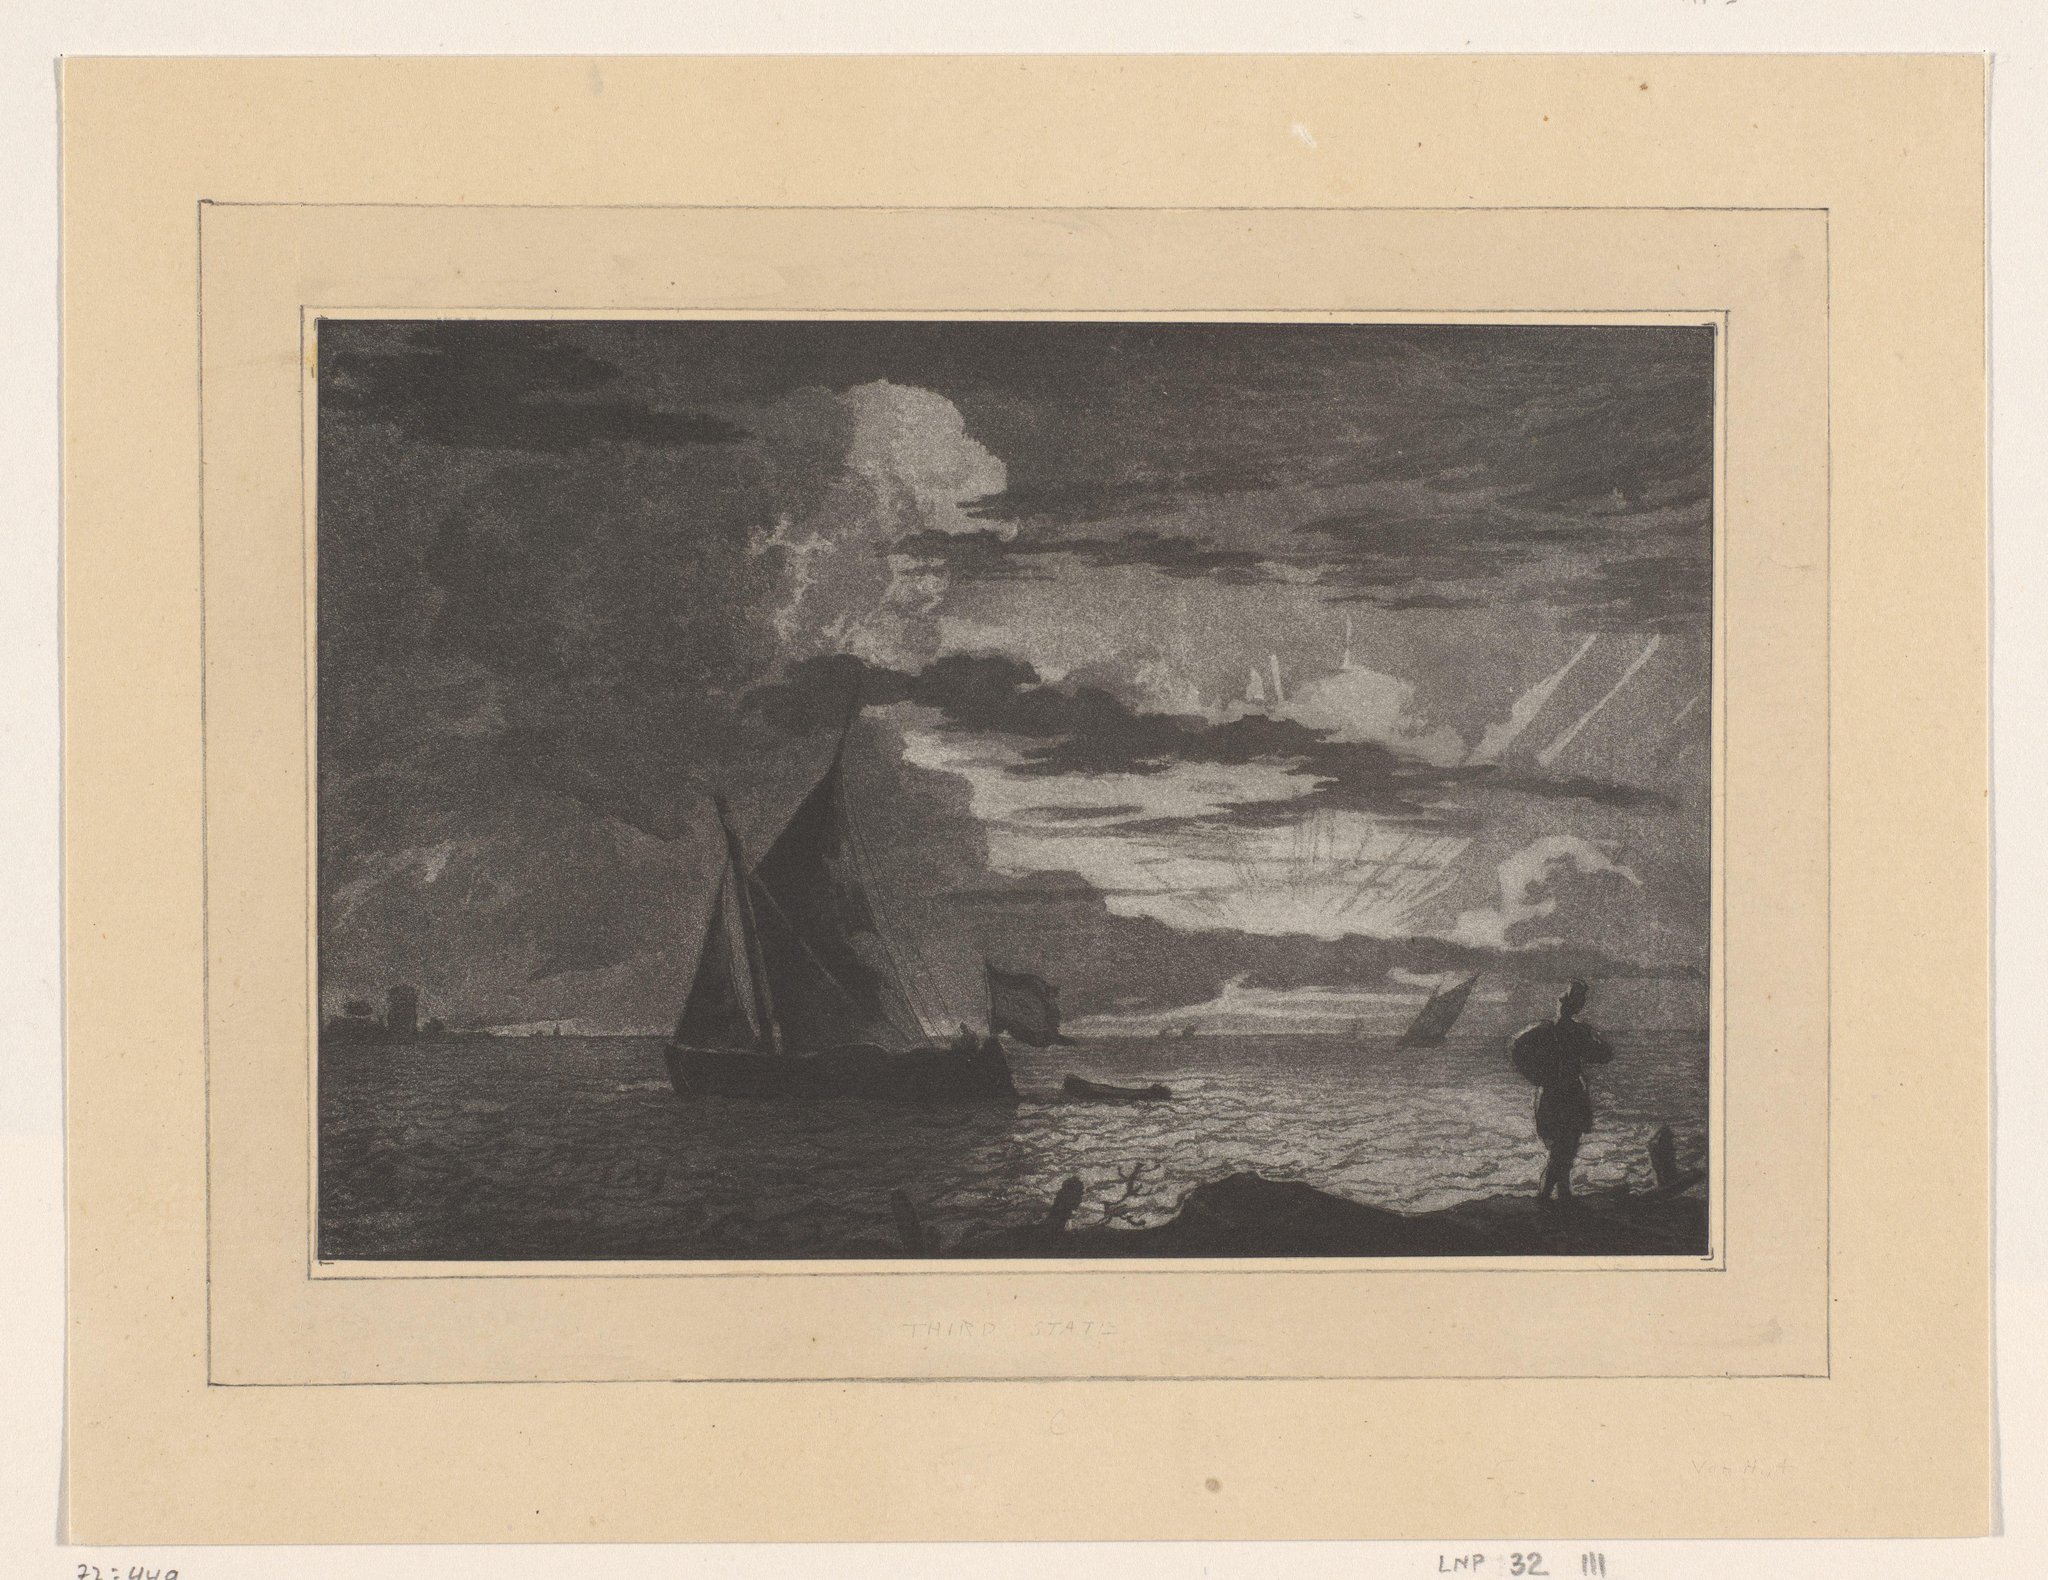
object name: print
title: Man met zak op de schouder bij zonsopgang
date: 1779-1781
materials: paper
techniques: etching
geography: amsterdam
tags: sailing-ship, sailing-boat, sunrise, carrying something on the head or on the shoulders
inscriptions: collector's mark: Lugt 2228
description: Rechts op de voorgrond een man met een zak op de schouder, kijkend naar de schepen en de zonsopgang.